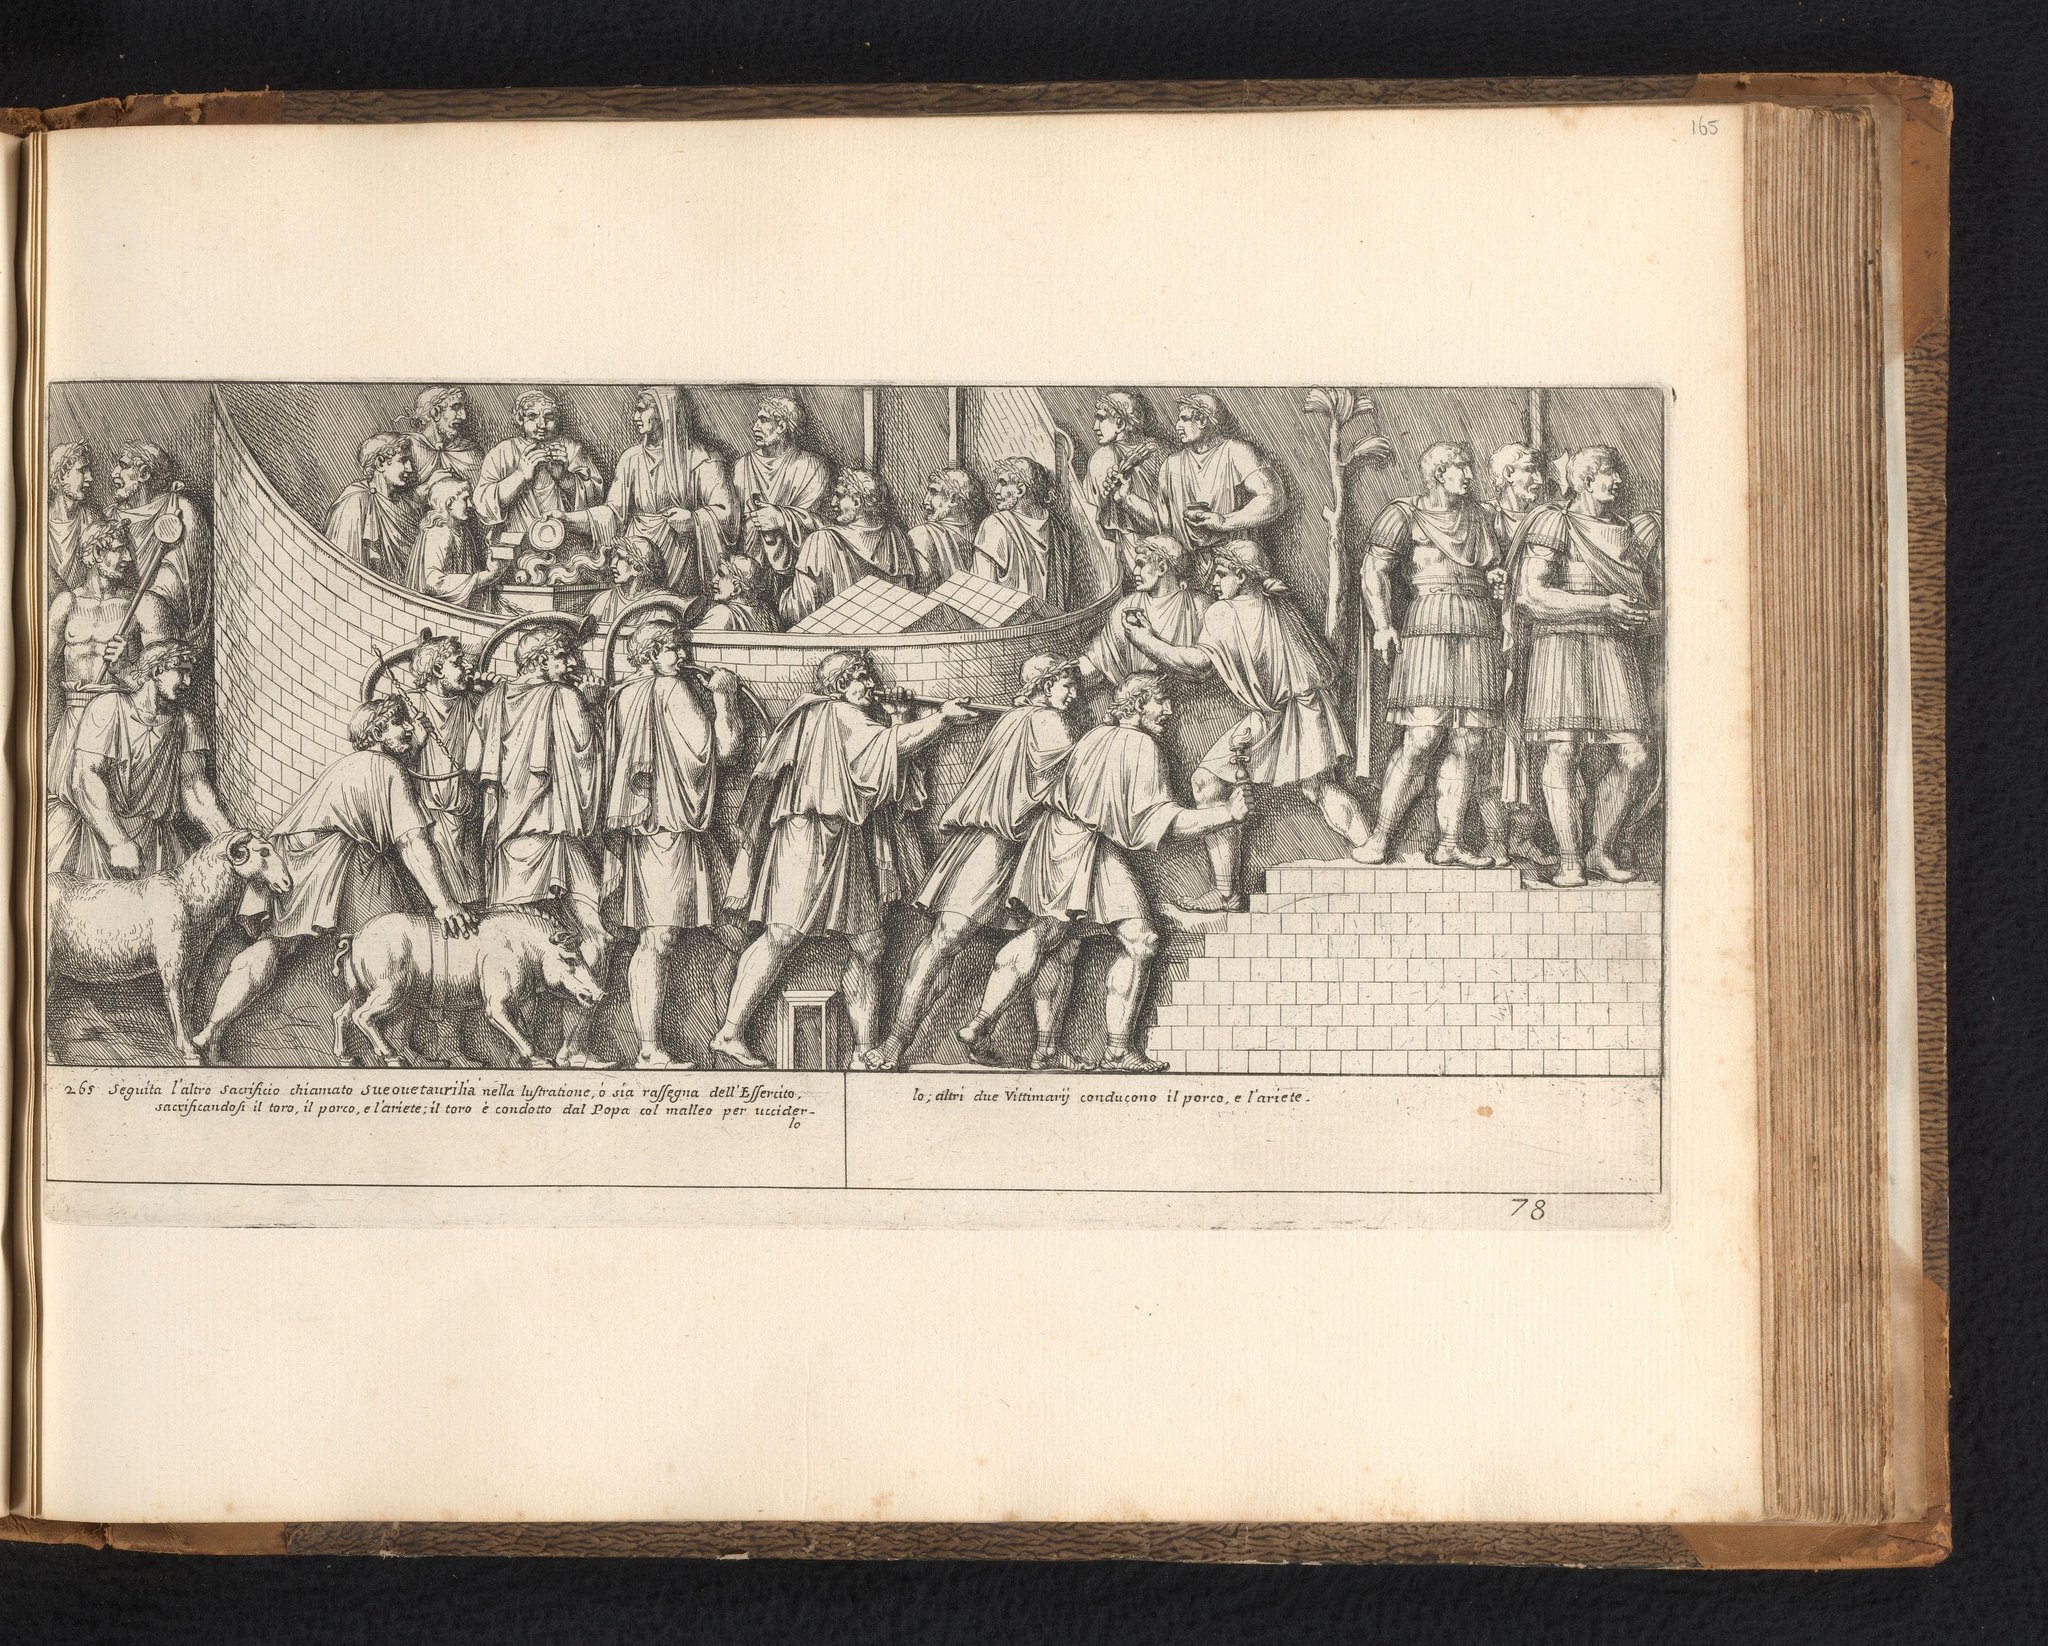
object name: print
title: Detail van het fries op de Zuil van Trajanus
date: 1637-1691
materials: paper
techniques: etching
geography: rome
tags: triumphal column with helical friezes, piece of sculpture, reproduction of a piece of sculpture, the soldier; the soldier's life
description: Detail van het spiraalvormige gebeeldhouwde fries op de Zuil van Trajanus. Het fries toont de oorlogen tussen de Romeinen en de Daciërs. Verklarende nummers in de ondermarge. Prent maakt deel uit van een album.